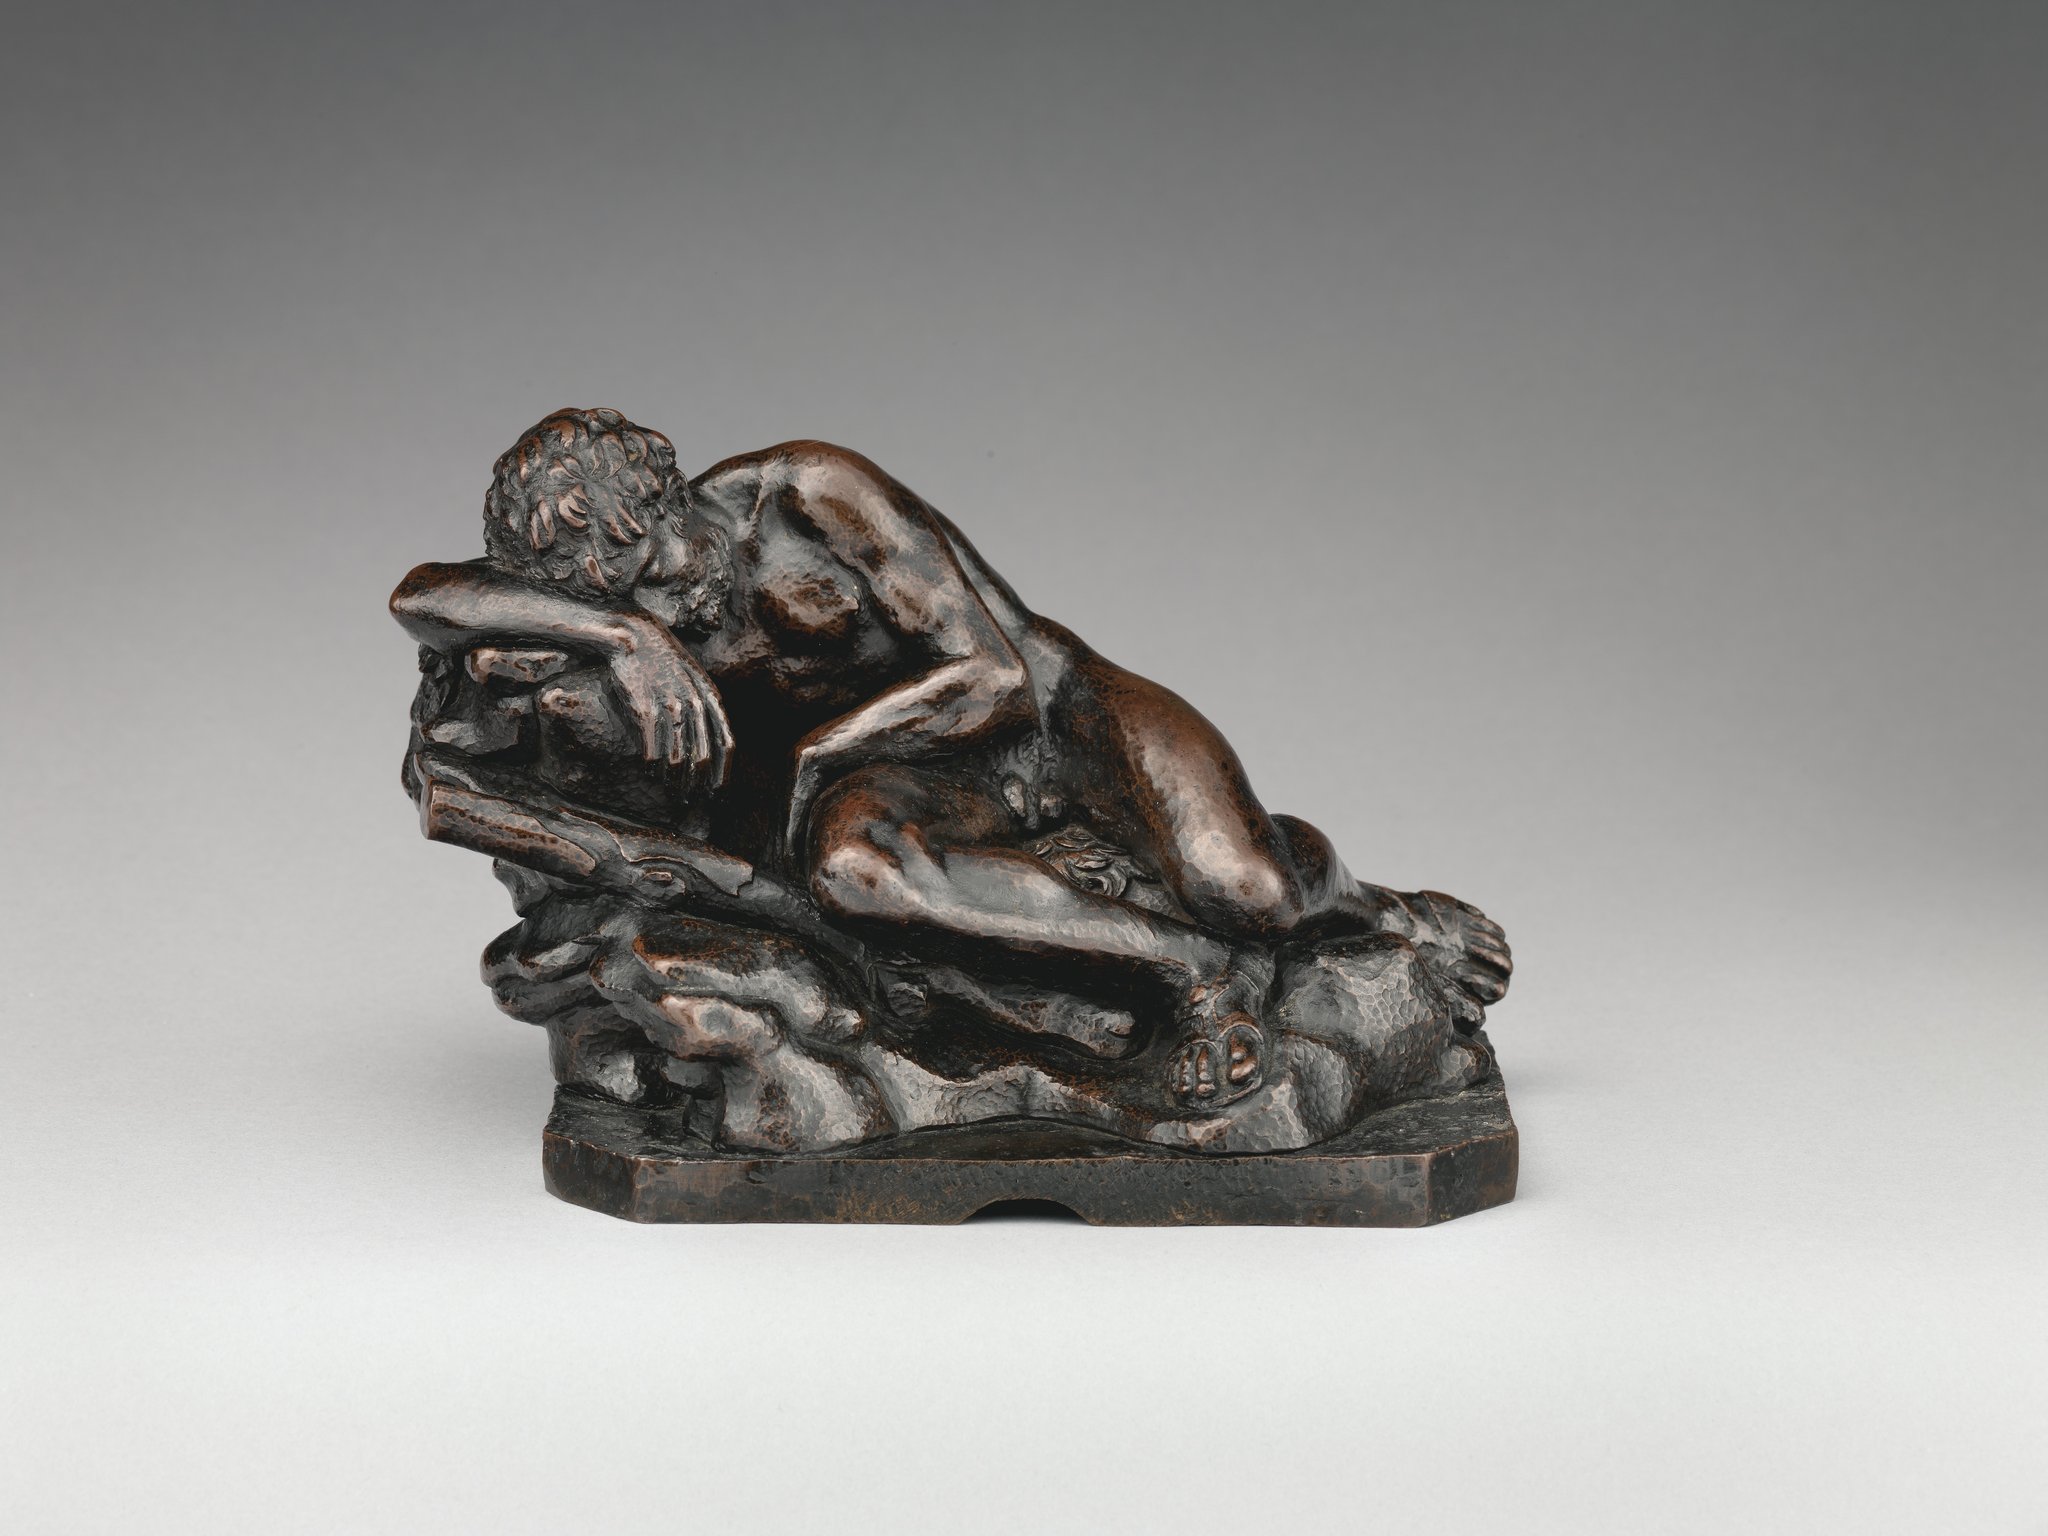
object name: statuette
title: Sleeping Hercules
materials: bronze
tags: hercules